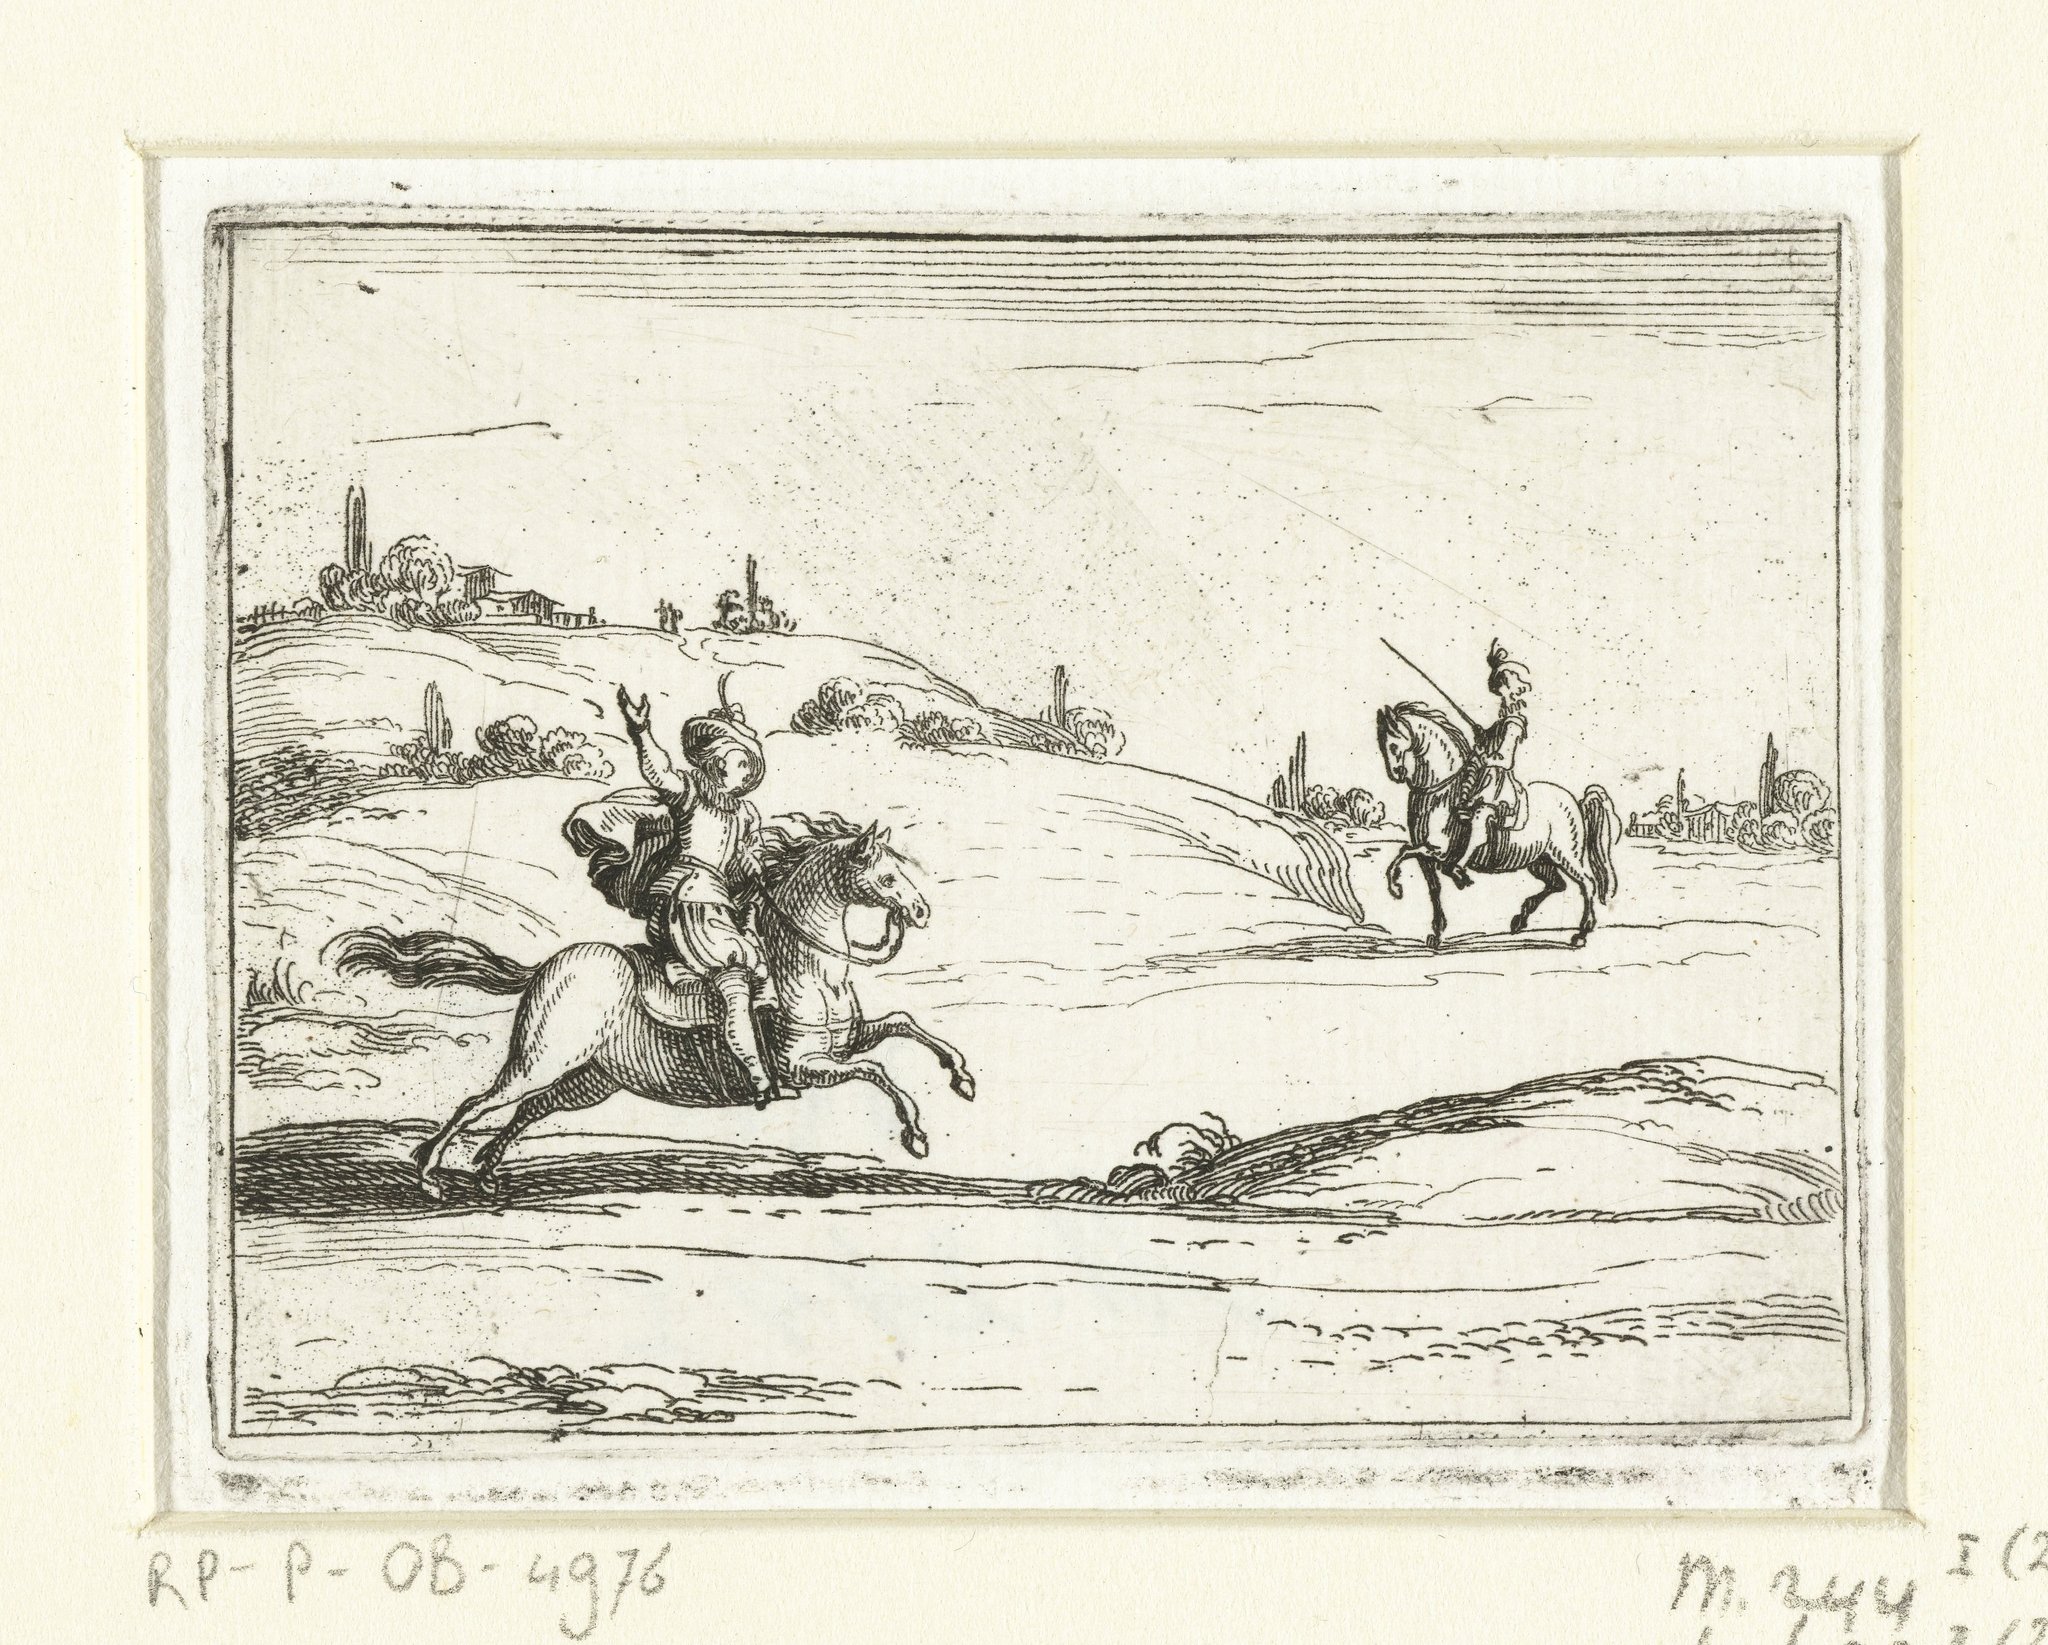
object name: print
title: Twee ruiters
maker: jacques callot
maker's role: draughtsman, print maker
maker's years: 1592-1635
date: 1621-1635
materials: paper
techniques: etching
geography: nancy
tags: riding a horse, ass, or mule; rider, horseman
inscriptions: collector's mark: Lugt 240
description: Voorstelling van een ruiter op een paard in galop (links) en een tweede ruiter op een paard dat rustig loopt (rechts). Dit blad is onderdeel van de embleemserie 'Kloosterleven in emblemen'. De tweede staat van deze serie behelst naast een geïllustreerde titelpagina en 26 emblemen nog een titelpagina en een blad met opdracht, beide in boekdruk zonder afbeelding.